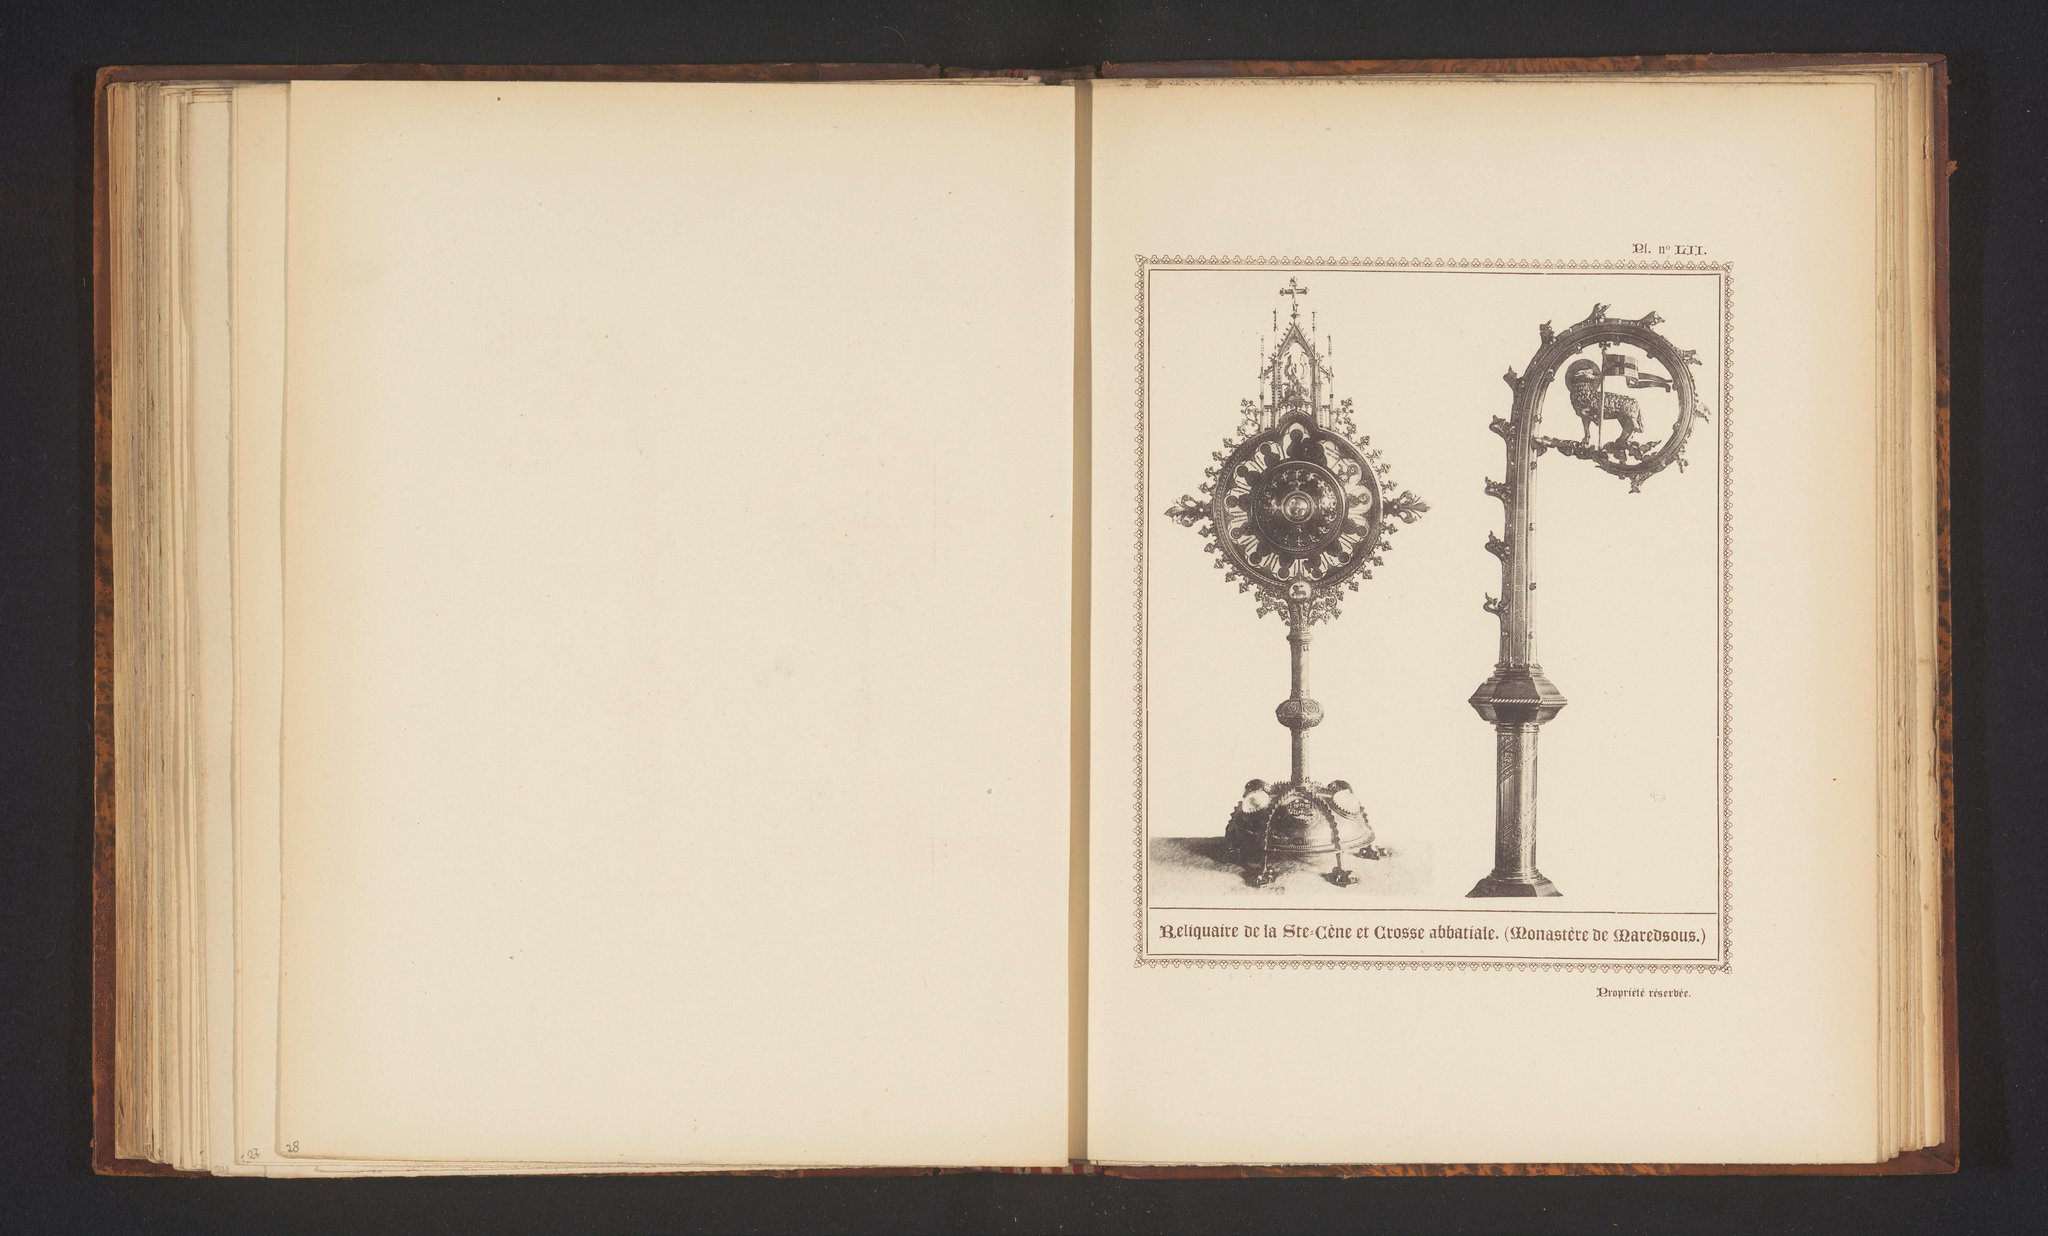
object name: page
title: Relikwieënkast van het heilig avondmaal en abdij-kruis in het klooster van Maredsous, België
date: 1891-1896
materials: paper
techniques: photograph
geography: maredsous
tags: relics (and reliquaries), the cross ~ symbols of christ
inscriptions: number: ‘Pl. no LII.’, inscription: ‘Propriété réservée.’